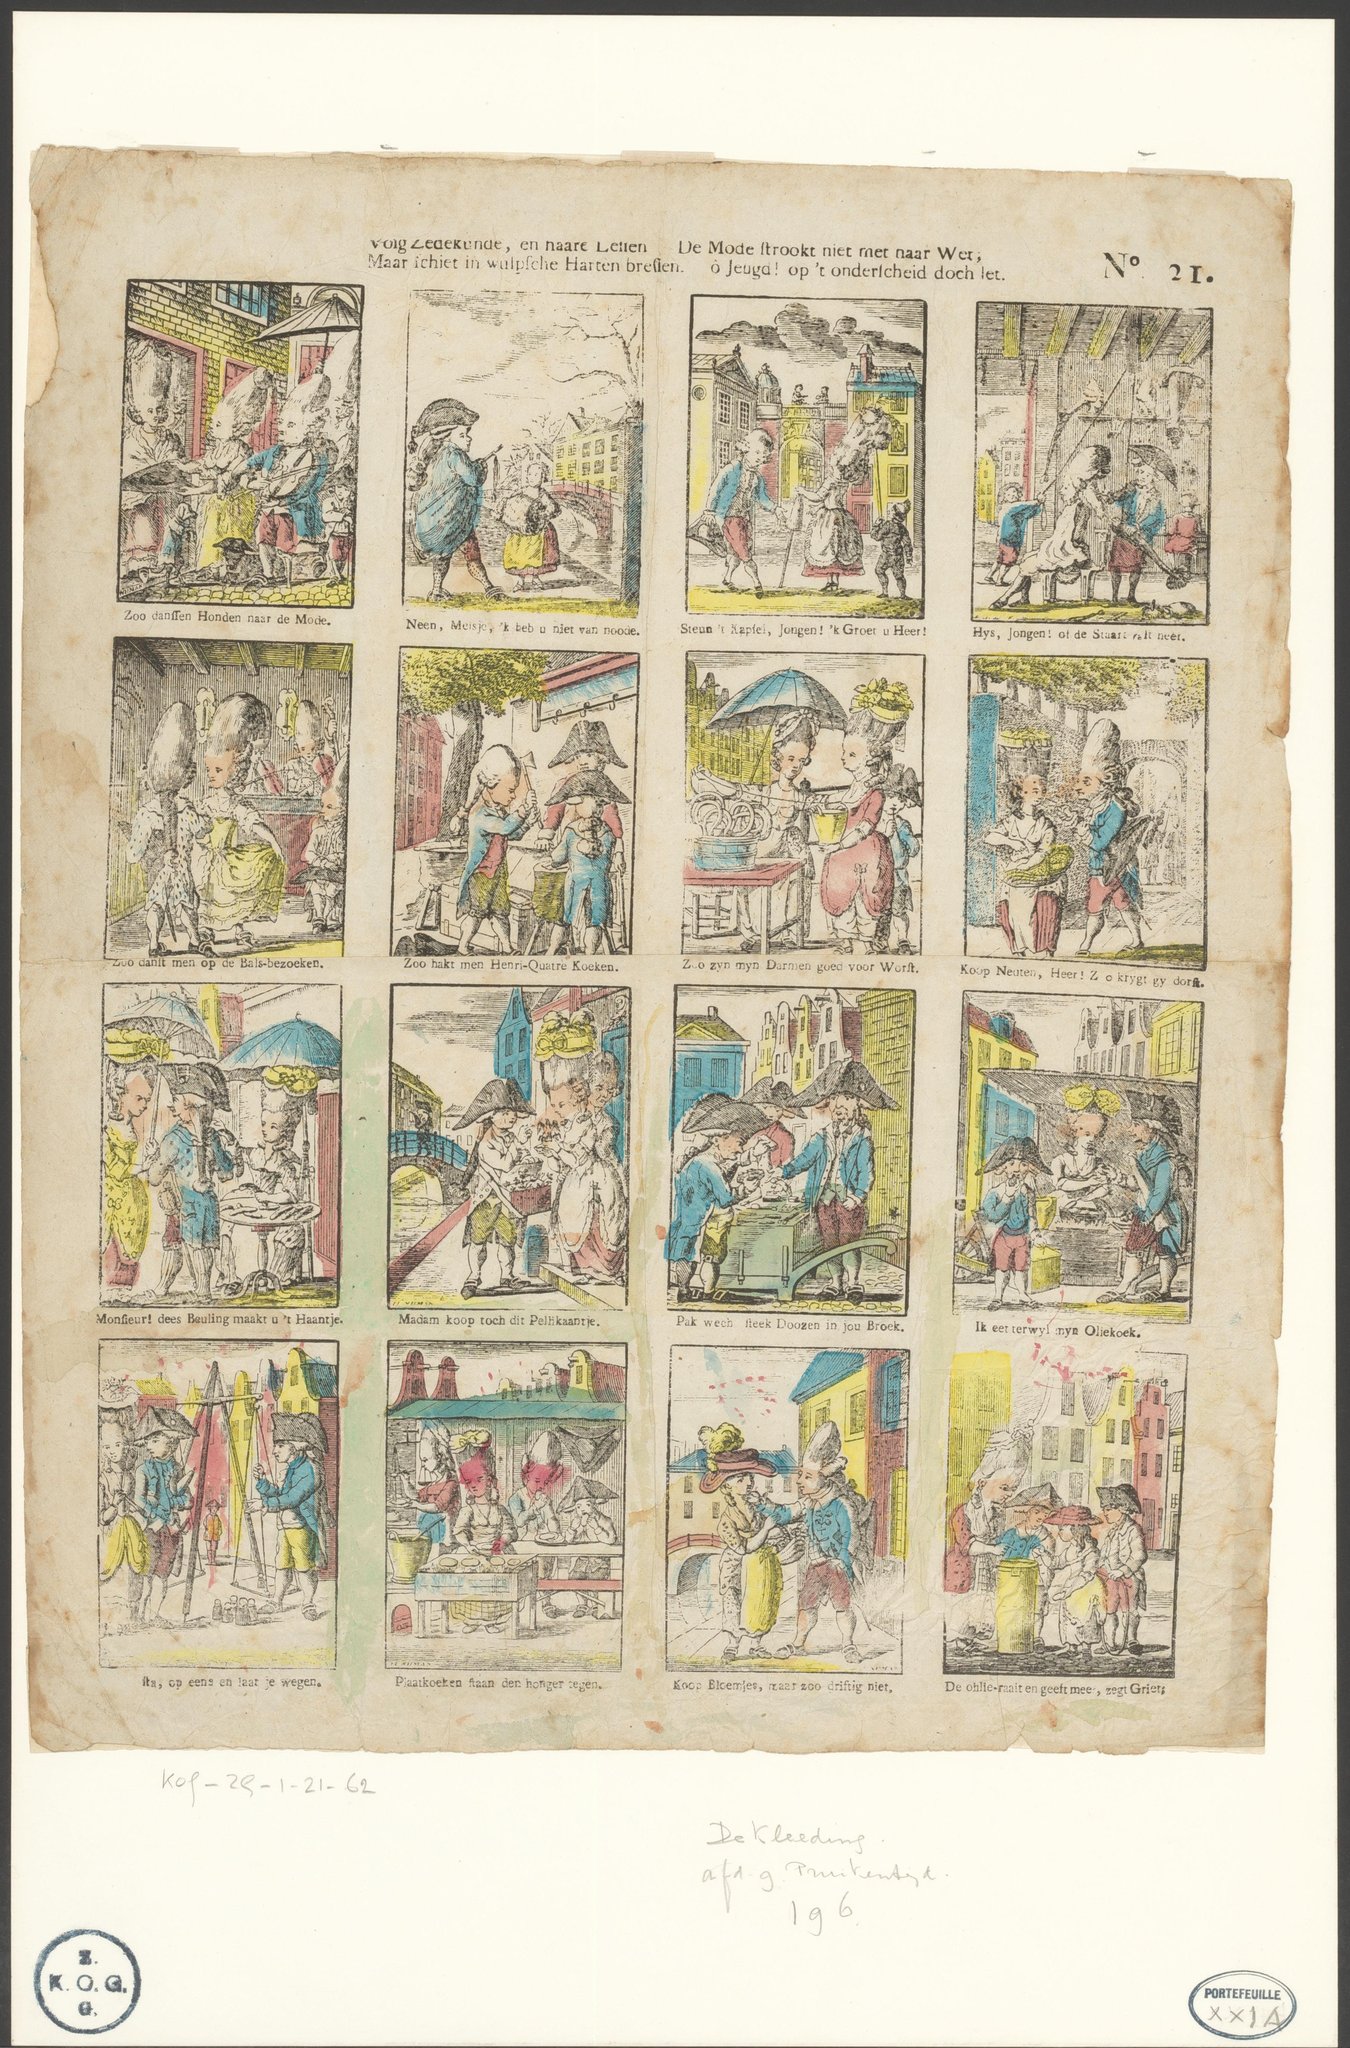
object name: popular print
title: Grote pruiken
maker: johan noman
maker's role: printer, publisher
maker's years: -1833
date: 1806-1900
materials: paper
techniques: hand coloring, letterpress printing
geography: zaltbommel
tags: head-gear: bicorne, bicorn, wig - aa - ~ women, styles of hairdress, comedy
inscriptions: collector's mark: Lugt 1641, stamp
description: Volksprent met zestien voorstellingen over extreem grote pruiken in vier rijen van vier. Onder elke voorstelling een regel tekst. Rechtsboven genummerd: No. 21. Onderwerpsrubrieken binnen de Atlas Zeden en Gewoonten: Zeden en Gewoonten in Engeren Zin, De Kleeding, Kleederdrachten (tijdvakken), De 18de eeuw (de pruikentijd). Mannen en vrouwen.